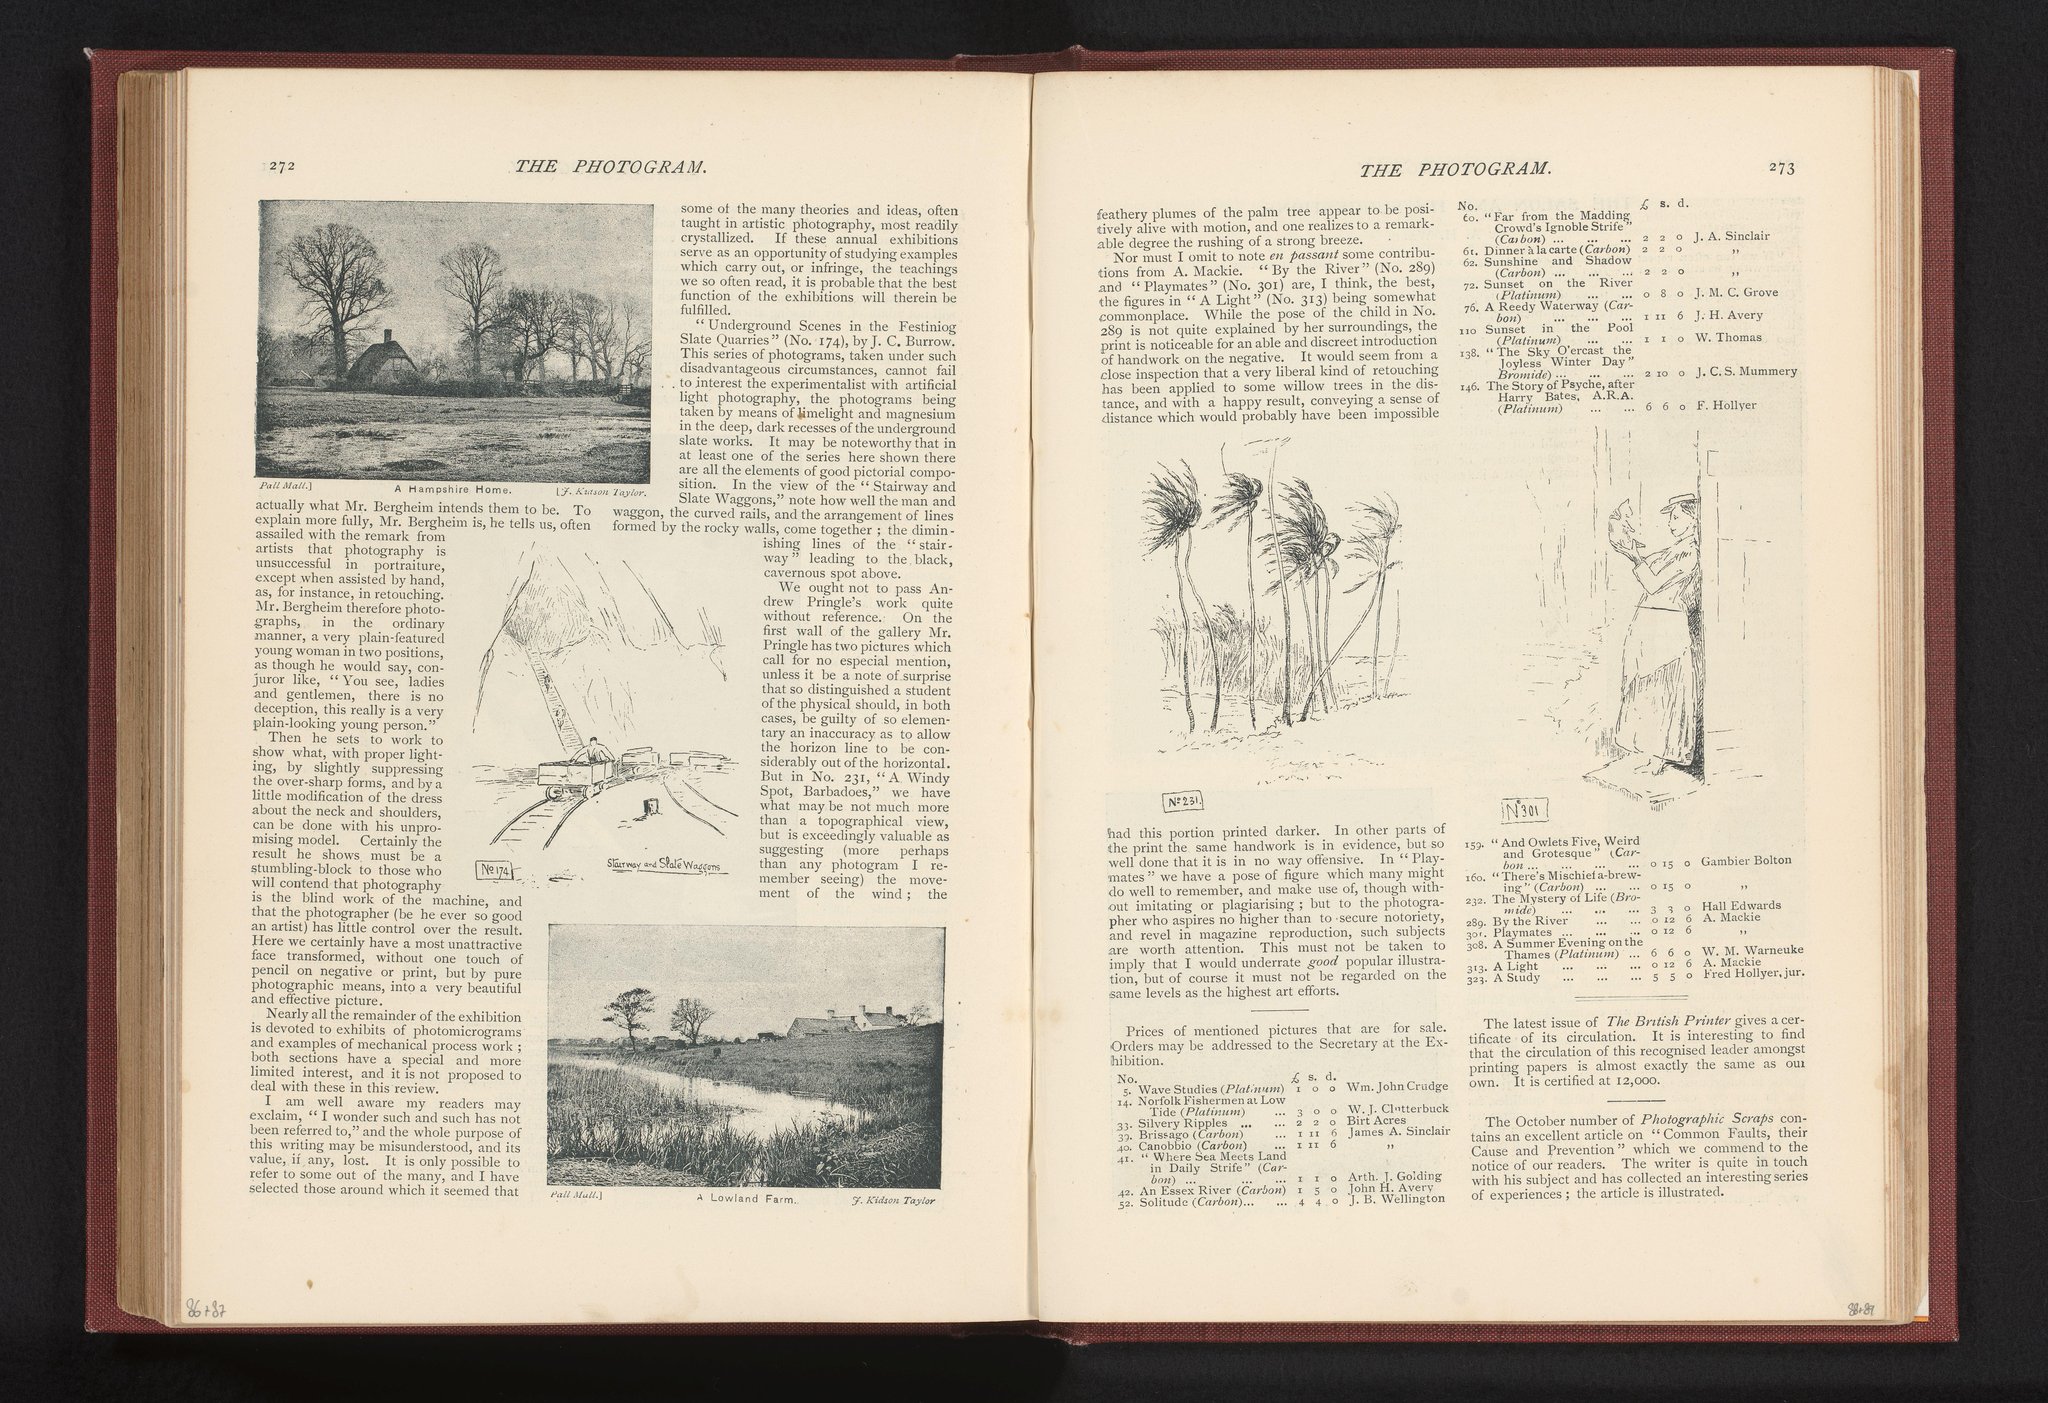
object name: photomechanical print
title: A lowland farm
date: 1889-1894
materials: paper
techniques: autotype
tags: landscapes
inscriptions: inscription: ‘Pall Mall’